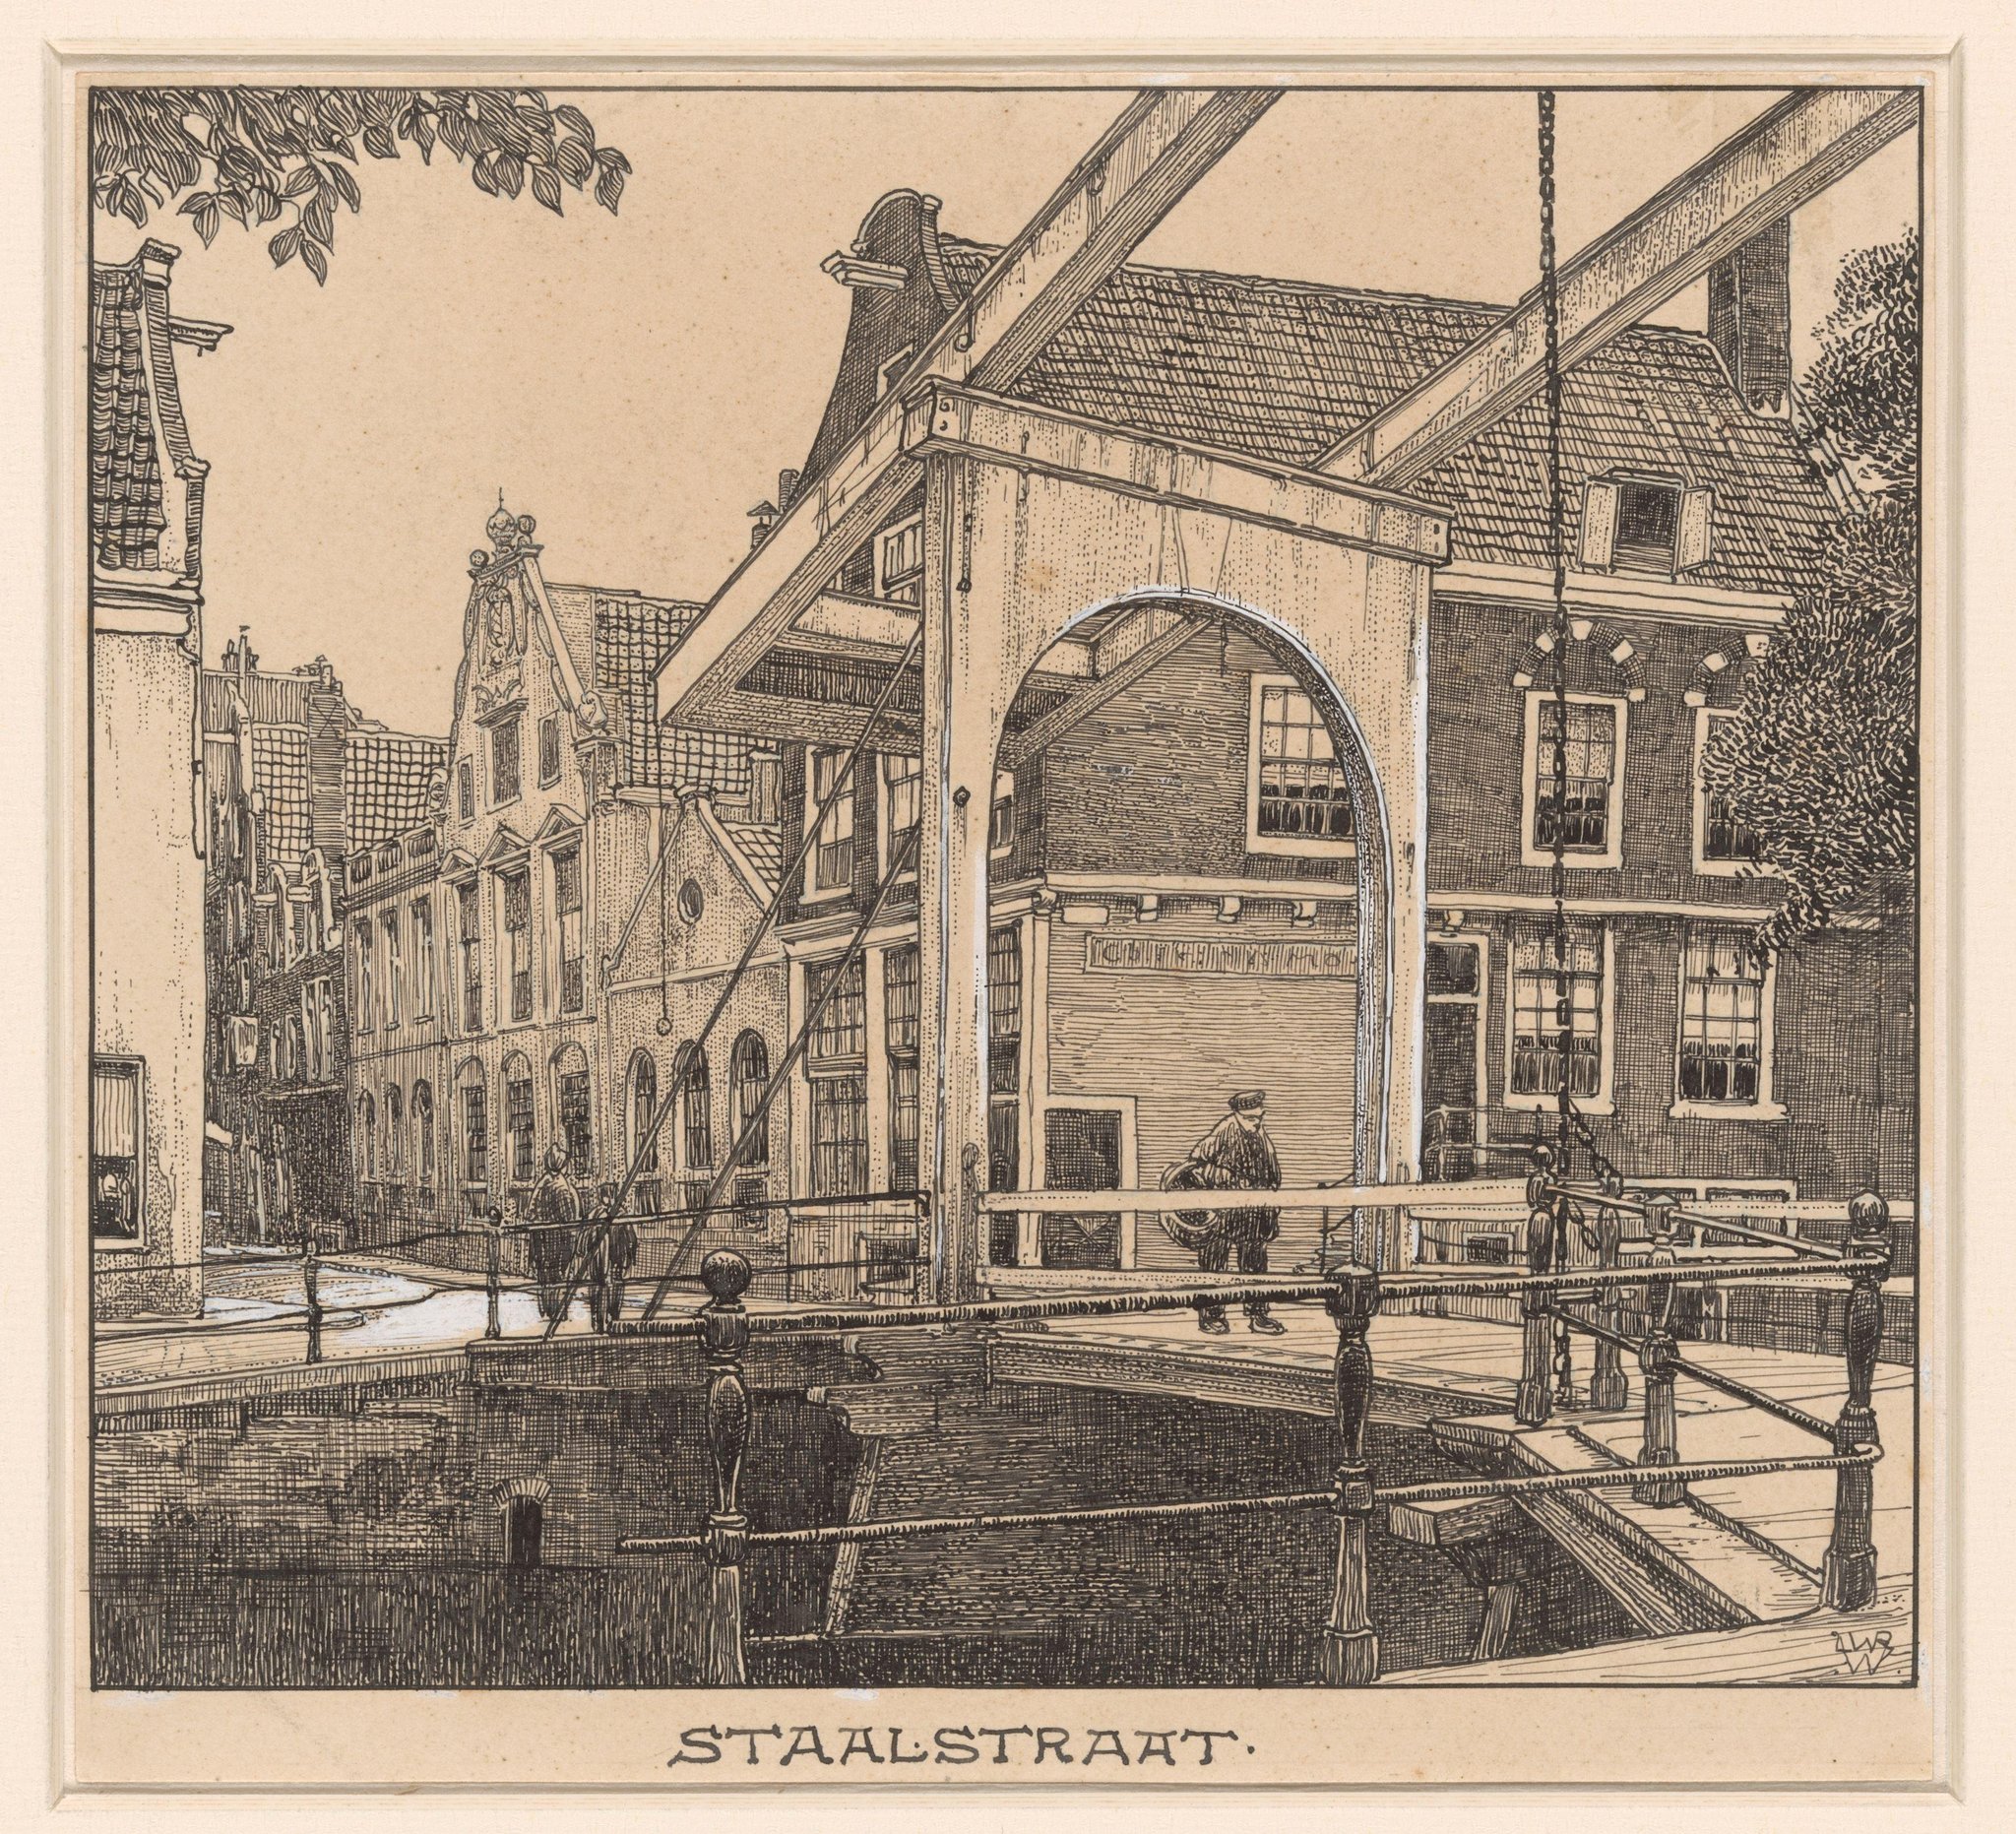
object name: drawing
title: Staalstraat te Amsterdam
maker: willem wenckebach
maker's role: designer, draughtsman, painter, print maker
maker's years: 1860-1937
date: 1870-1926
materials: paint, ink, paper, pencil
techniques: pen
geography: amsterdam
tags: bridge in city across river, canal, etc., street, amsterdam